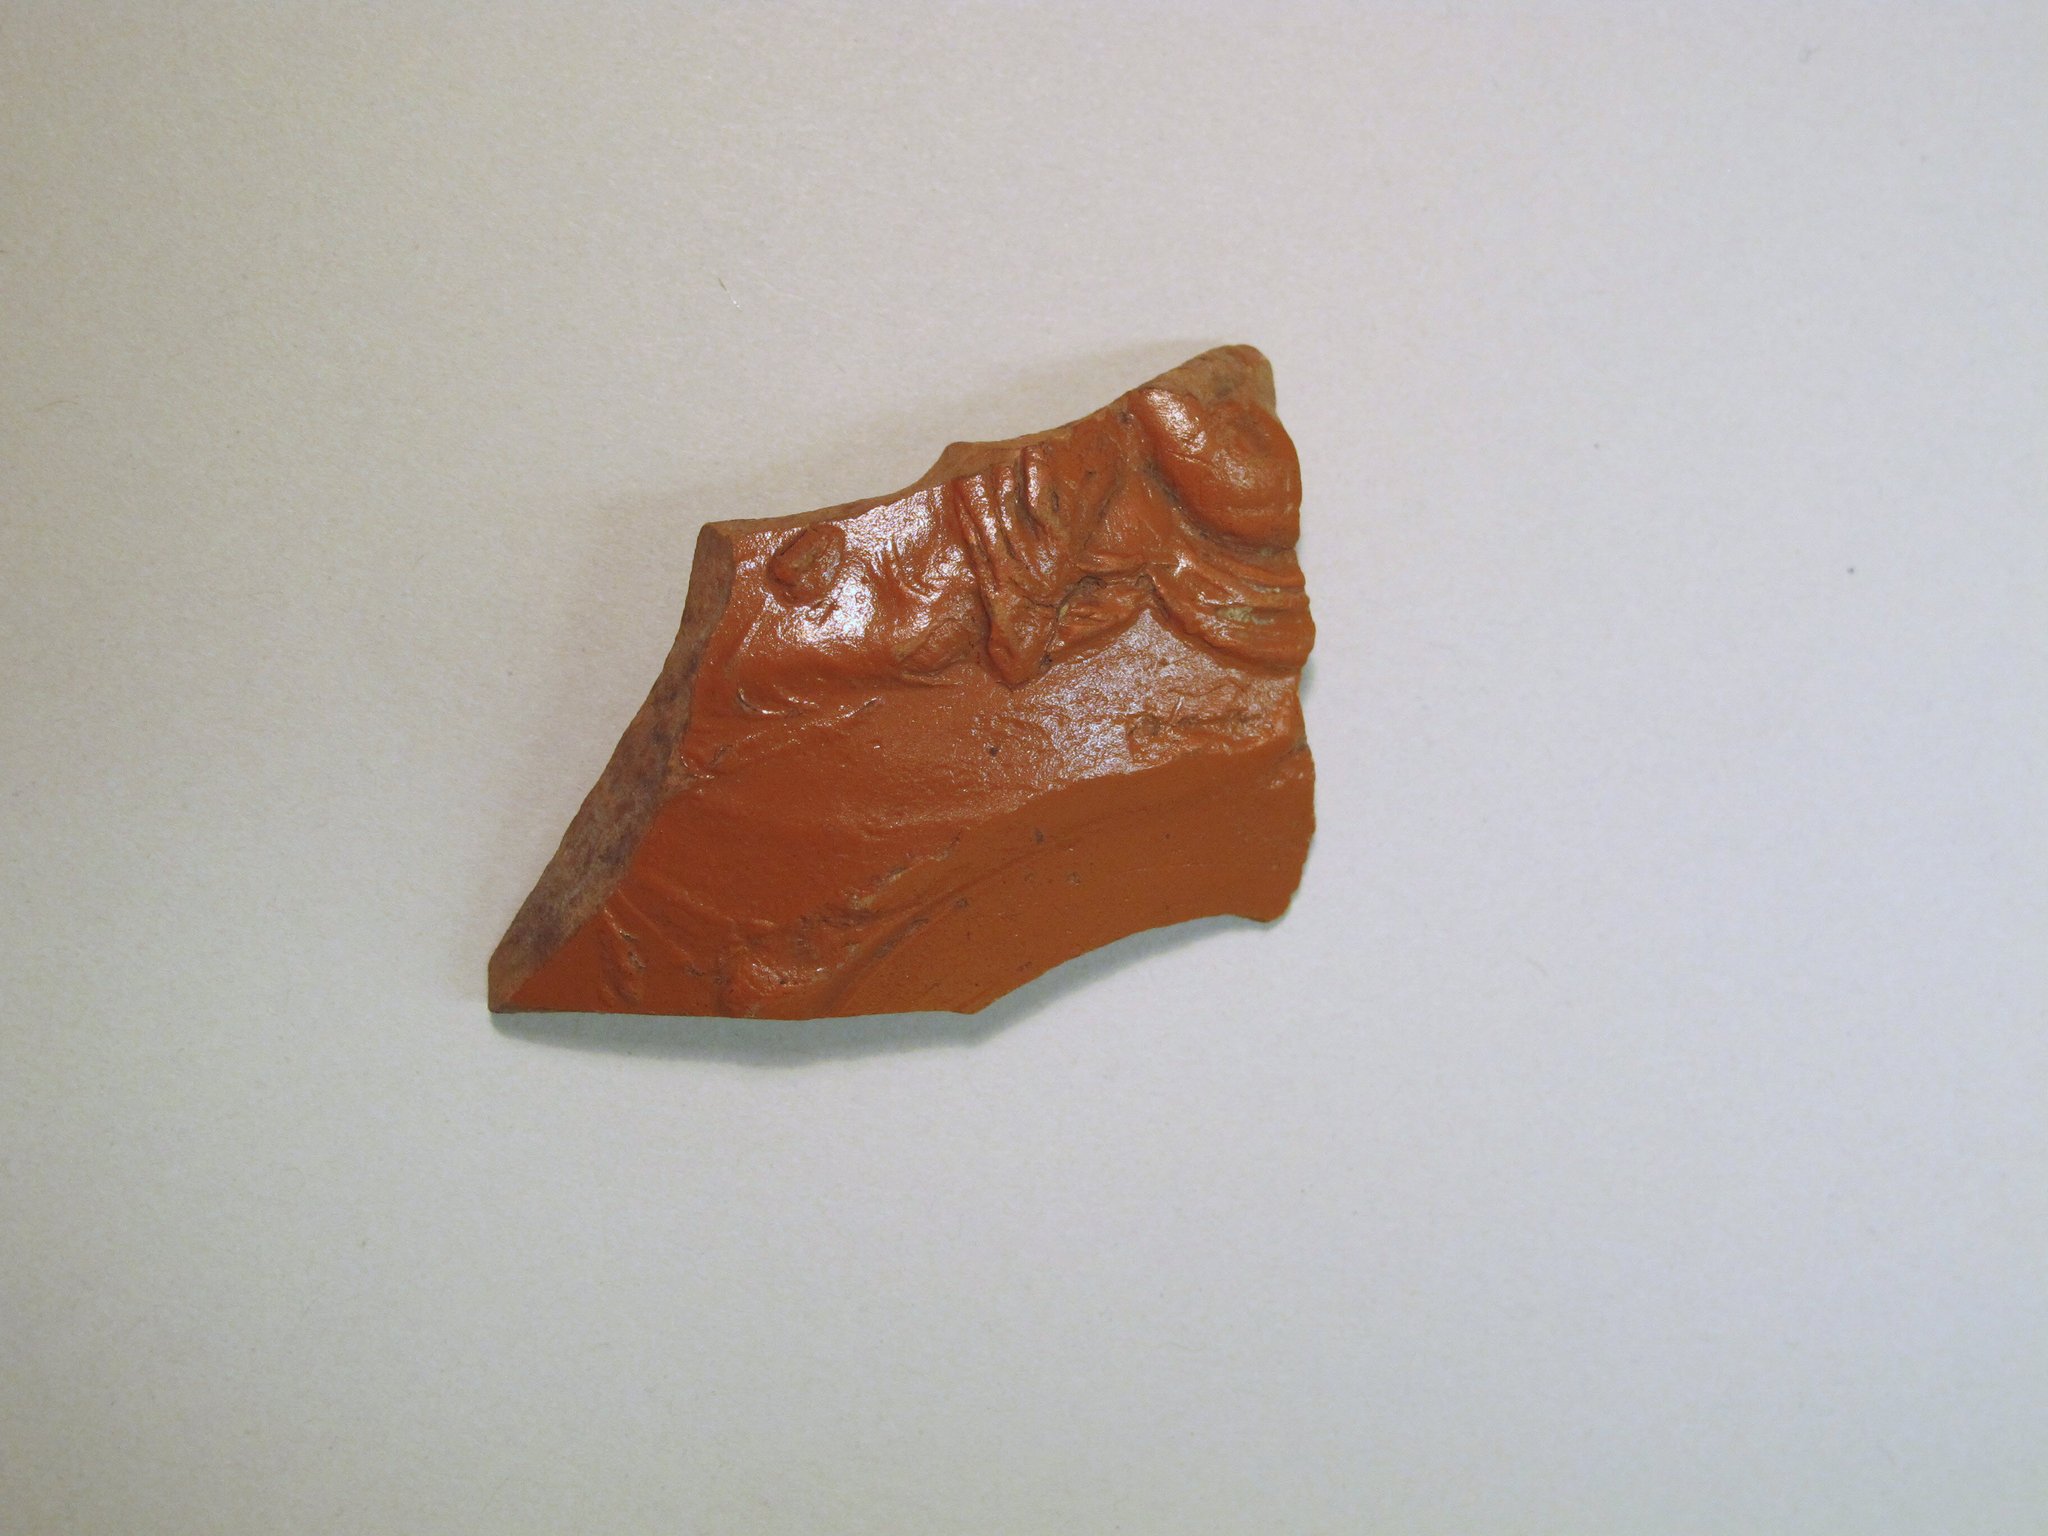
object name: vase fragment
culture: roman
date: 100 BCE-100 CE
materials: terracotta